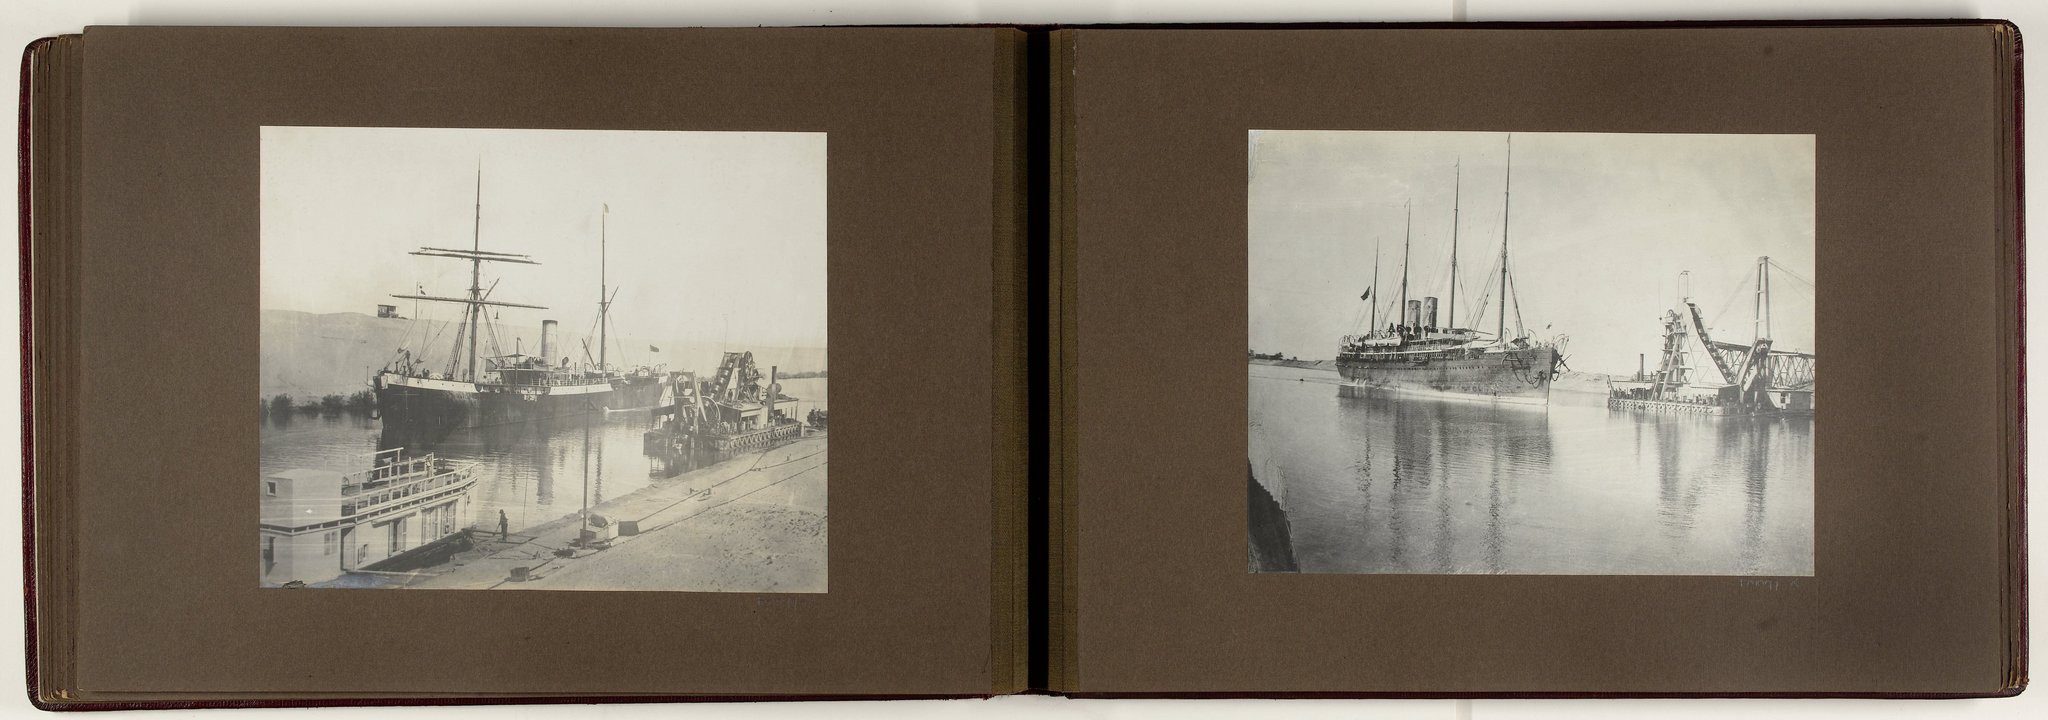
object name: photograph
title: Schip vaart door het Suezkanaal bij een baggerschip en een kade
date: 1880-1900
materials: paper, photographic support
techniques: gelatin silver print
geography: suez canal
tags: sailing-ship, sailing-boat, canal, dredge, dredging machine, quay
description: Onderdeel van Reisalbum met foto's van Duitsland, Zwitserland, het Suezkanaal en Nederlands-Indië.